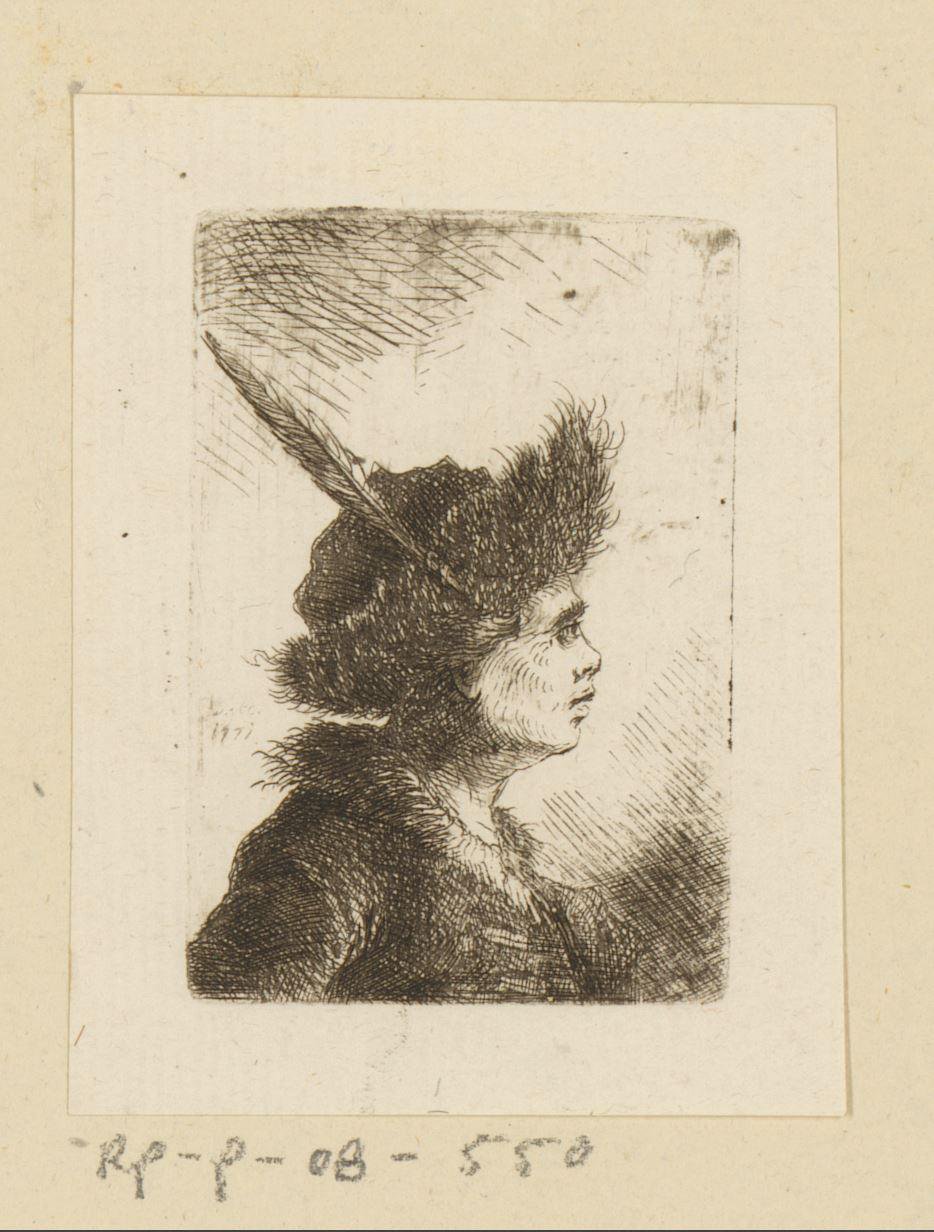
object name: print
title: Man met muts met veer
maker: johann andreas benjamin nothnagel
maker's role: print maker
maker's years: 1729-1804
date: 1771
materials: paper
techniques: etching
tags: head-gear: cap (+ men's clothes), adult man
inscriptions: collector's mark: Lugt 240